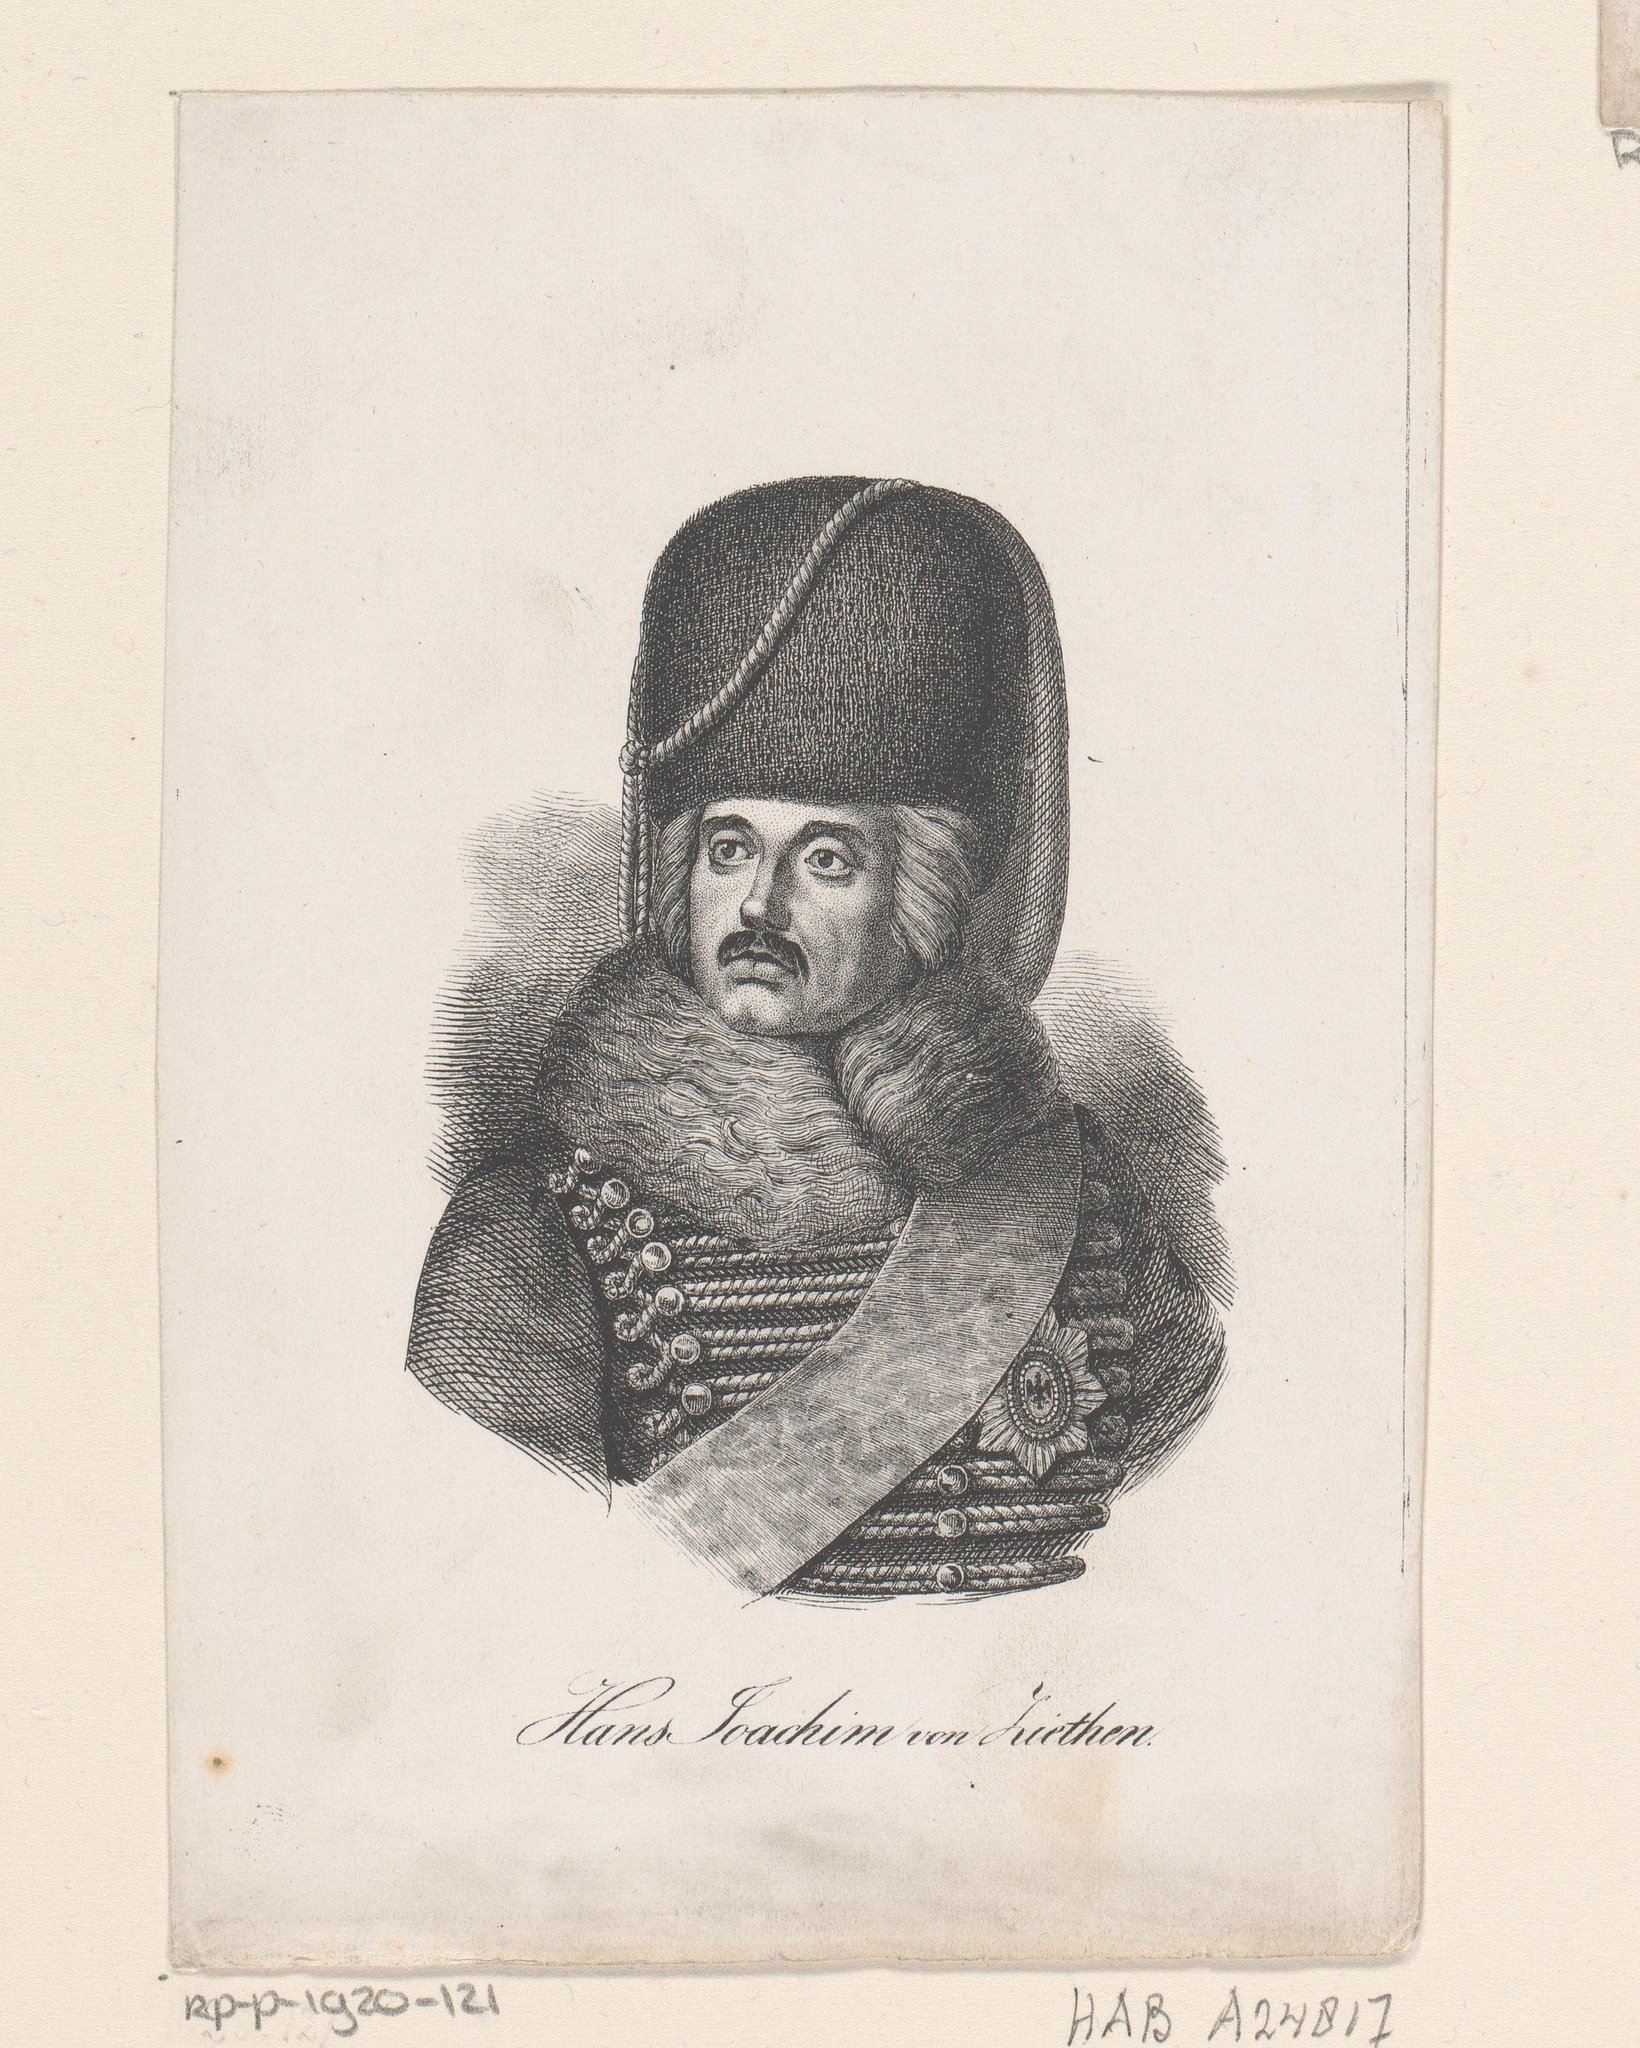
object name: print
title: Portret van Hans Joachim von Zieten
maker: Anonymous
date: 1843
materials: paper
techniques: engraving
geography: germany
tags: berlin, commander-in-chief, general, marshal, historical persons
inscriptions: collector's mark: Lugt 2228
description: Prent waarschijnlijk uit: Förster, Friedrich Christoph. Leben und Thaten Friedrich's des Grossen, Königs von Preussen. S.l.: s.n., 1843.